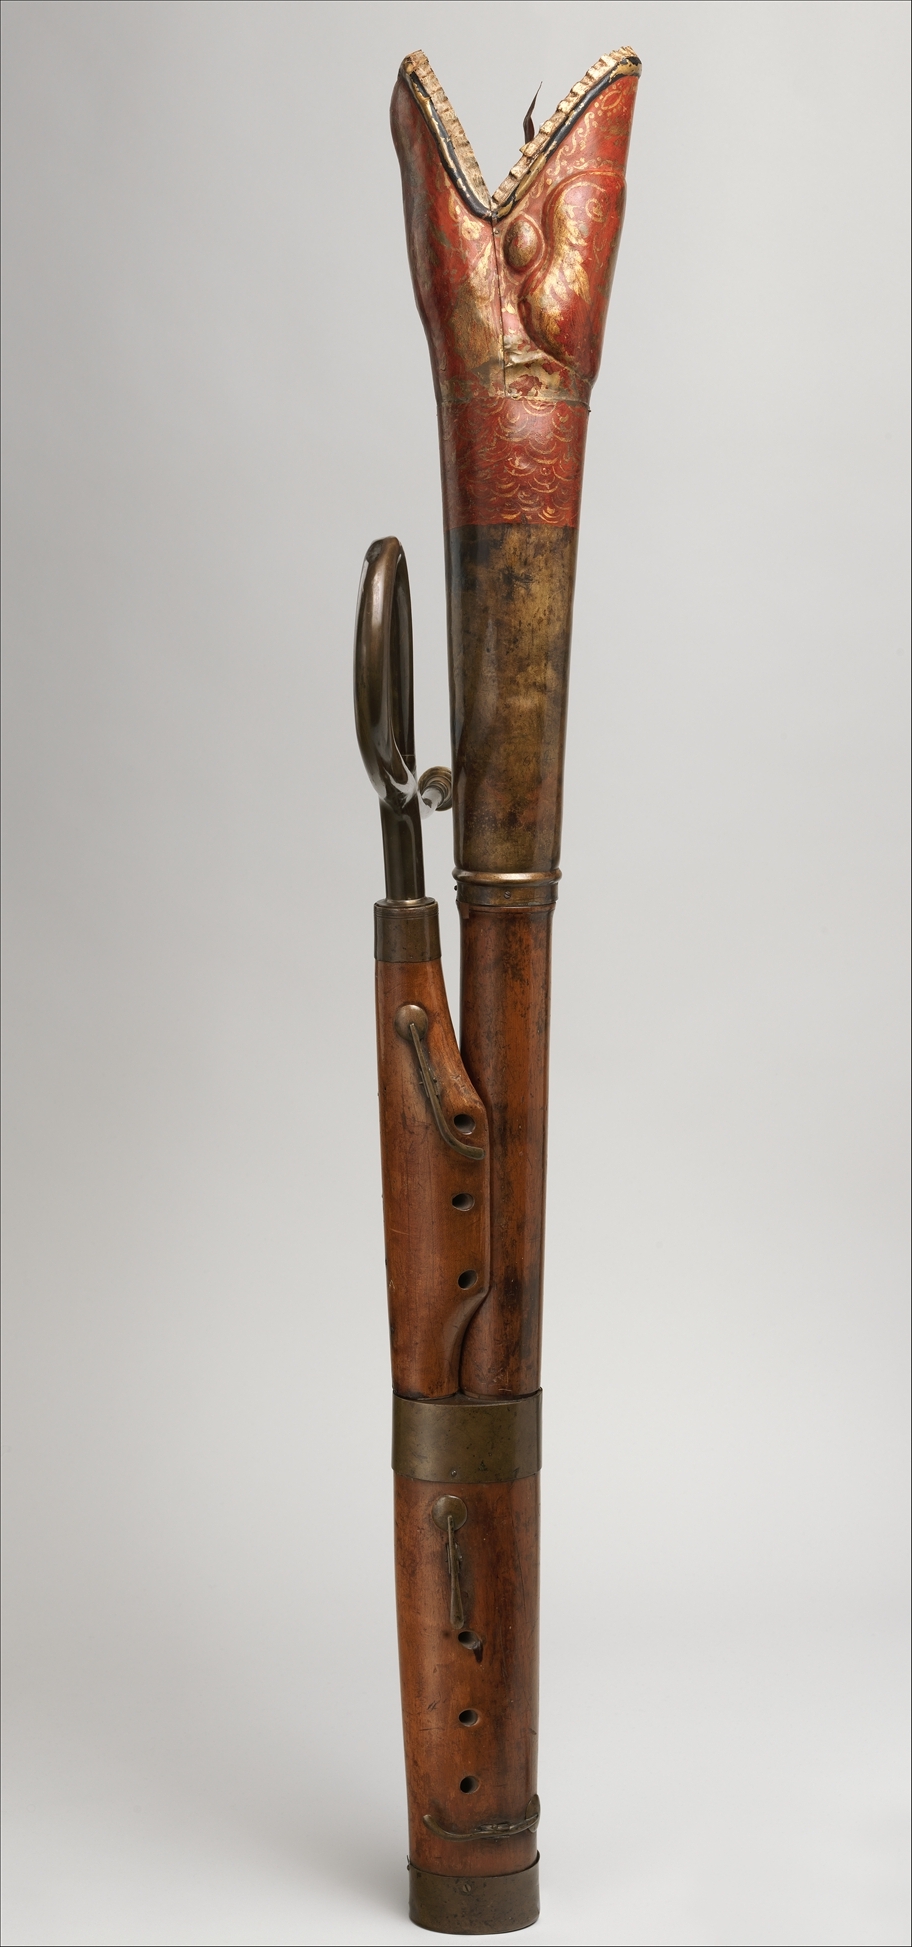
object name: russian bassoon in c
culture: french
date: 1825-1840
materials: brass, wood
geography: france